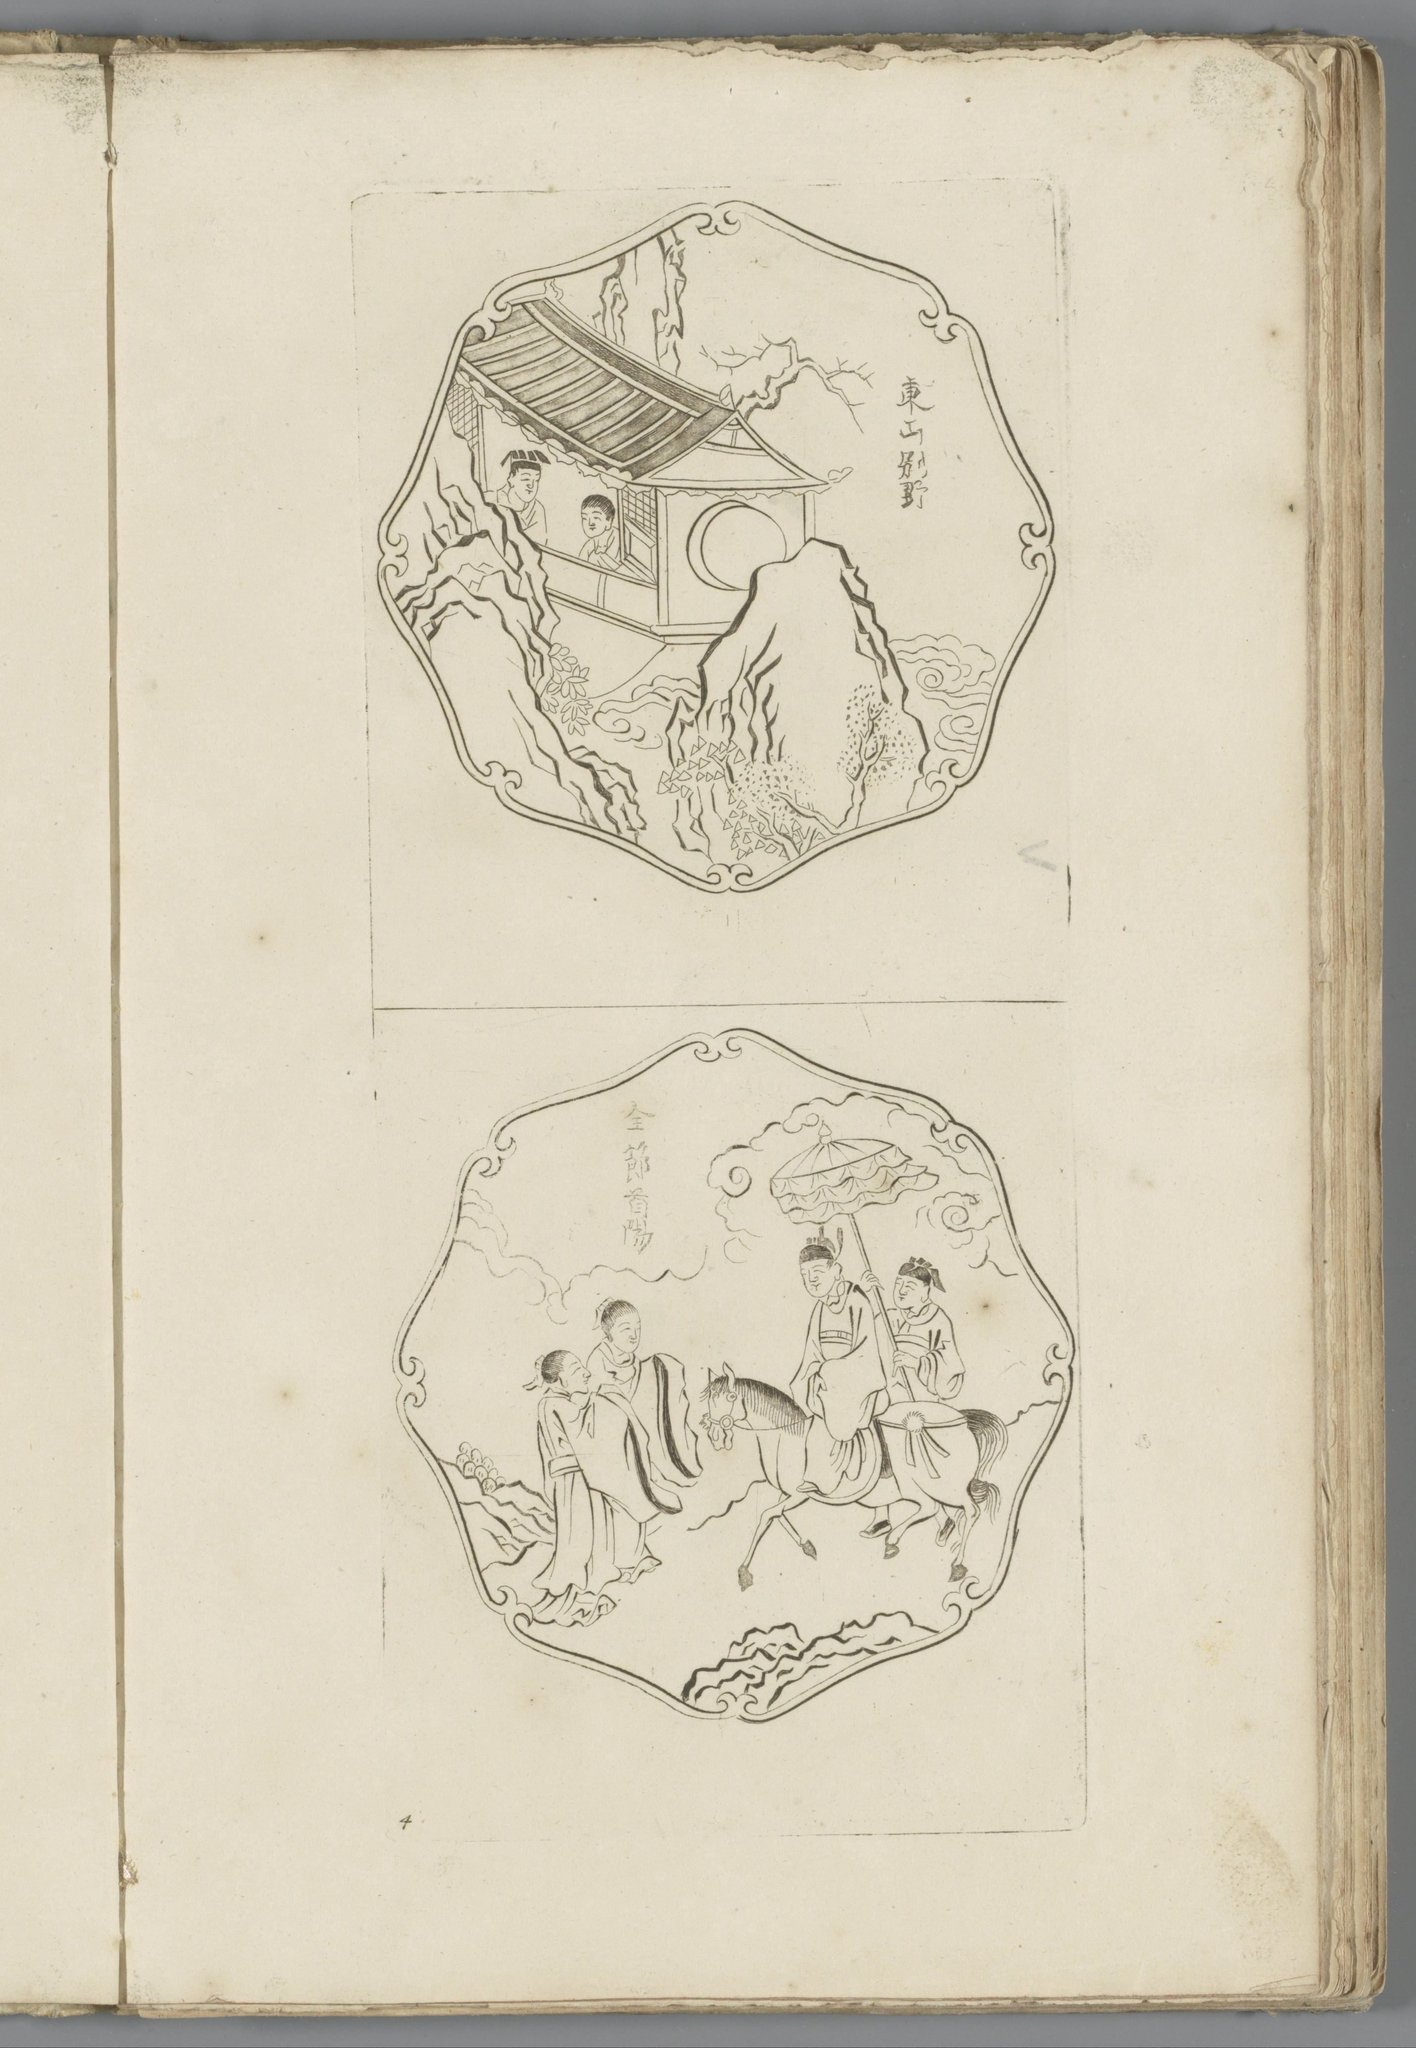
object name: print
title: Picturae Sinicae Ac Surattenae, Vasis Tabellisque exhibitae, Admiranda; colligente Petro Schenkio cum privil: Amstelaed: 1702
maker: pieter schenk (i)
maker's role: print maker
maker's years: 1660-1711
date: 1702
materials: paper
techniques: etching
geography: amsterdam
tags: riding a horse, ass, or mule; rider, horseman, chinese